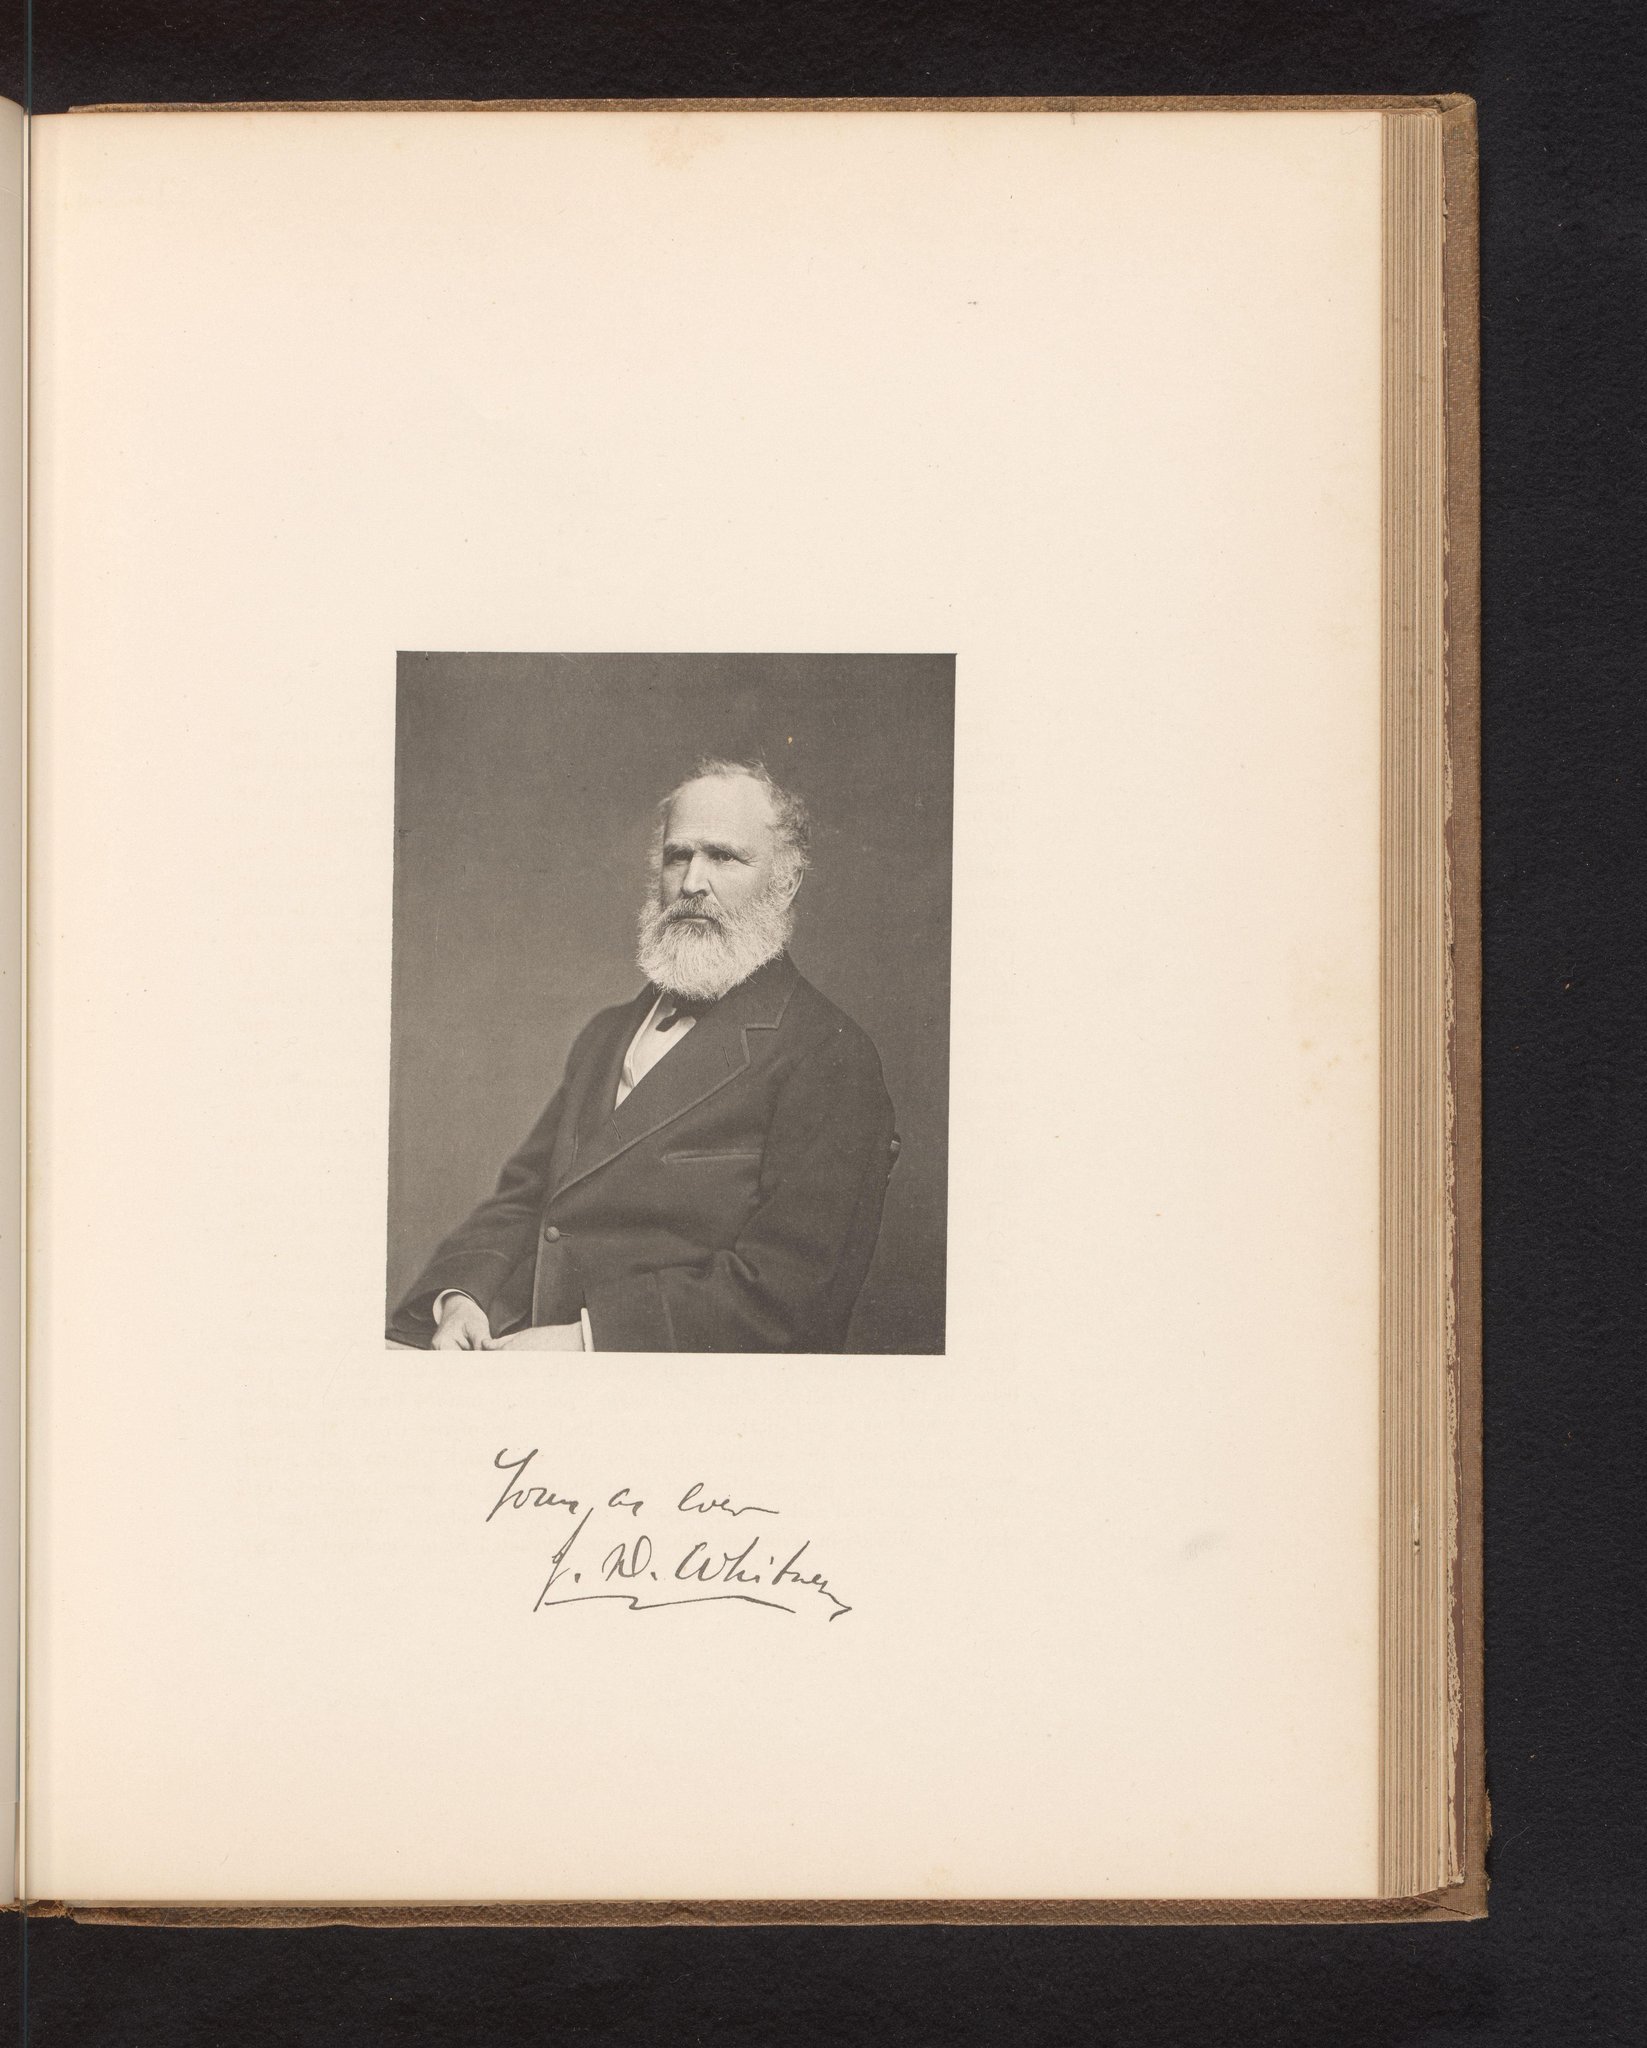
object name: photomechanical print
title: Portret van Josiah Whitney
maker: Anonymous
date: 1870-1875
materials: paper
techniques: photograph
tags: josiah whitney, historical persons, professor